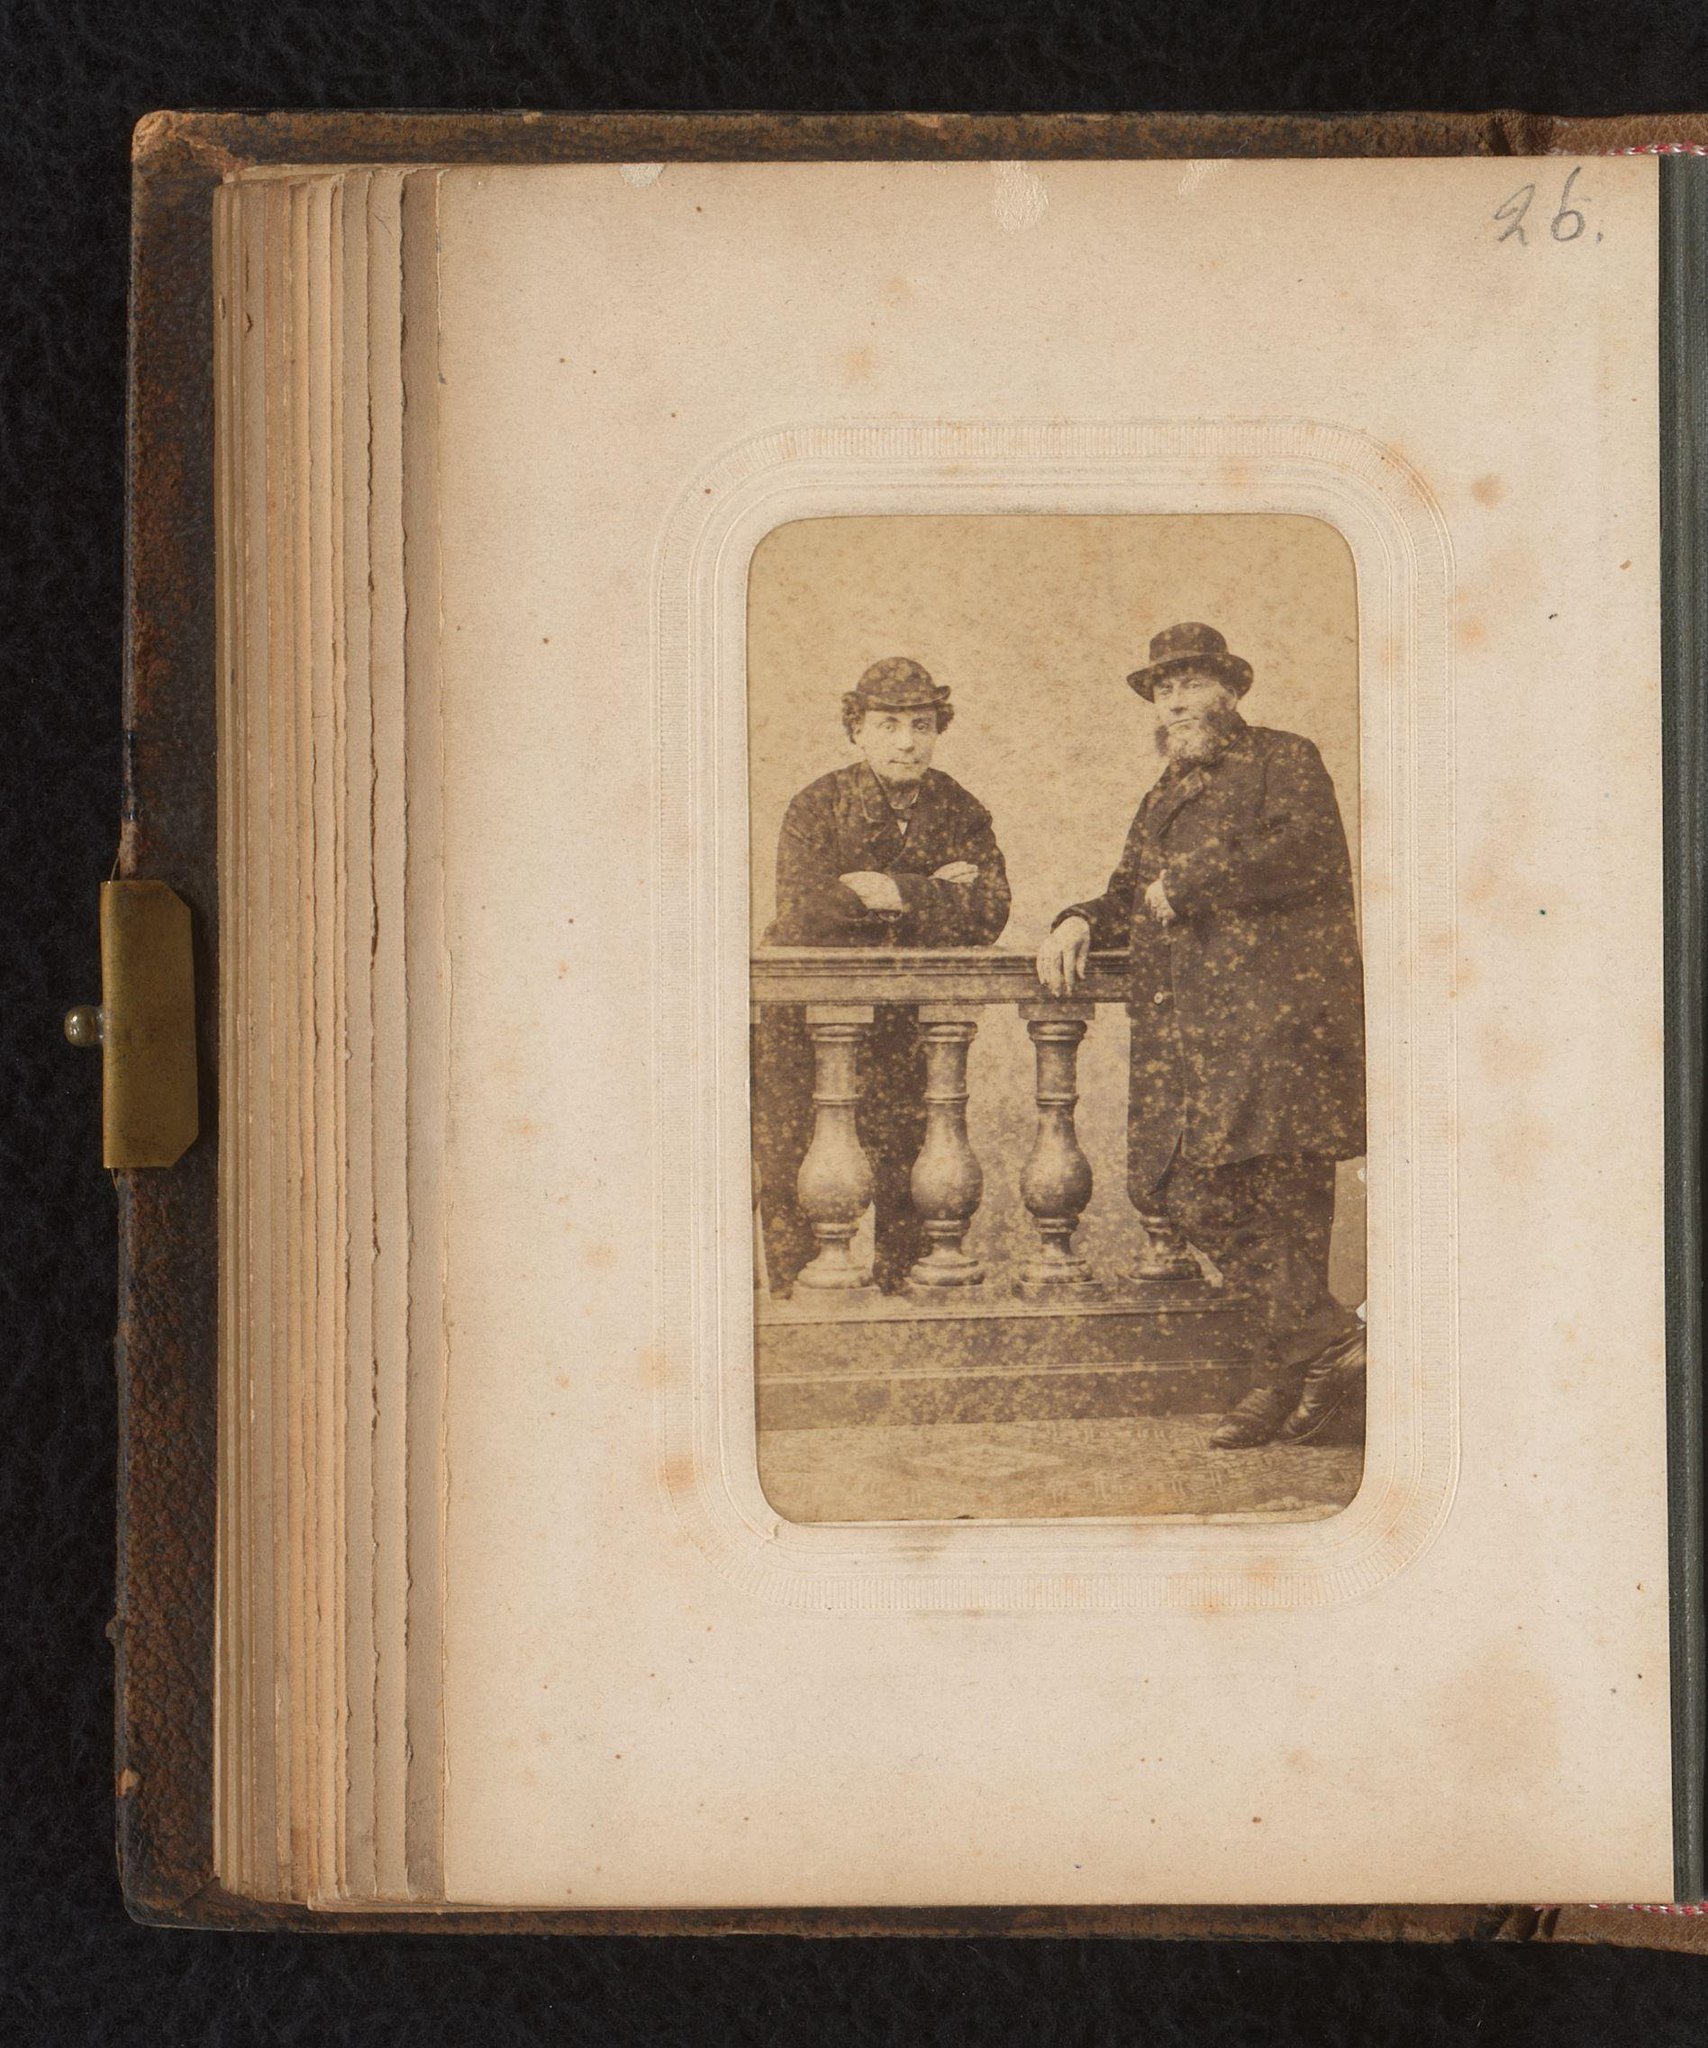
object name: album leaf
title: Portret van twee mannen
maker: klaas van vliet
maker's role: draughtsman, painter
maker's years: 1841-1917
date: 1860-1880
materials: cardboard, paper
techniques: albumen print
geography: krommenie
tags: historical persons not known by name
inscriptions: inscription: ‘Photographisch Atelier/ K. van Vliet Wz./ Krommenie’